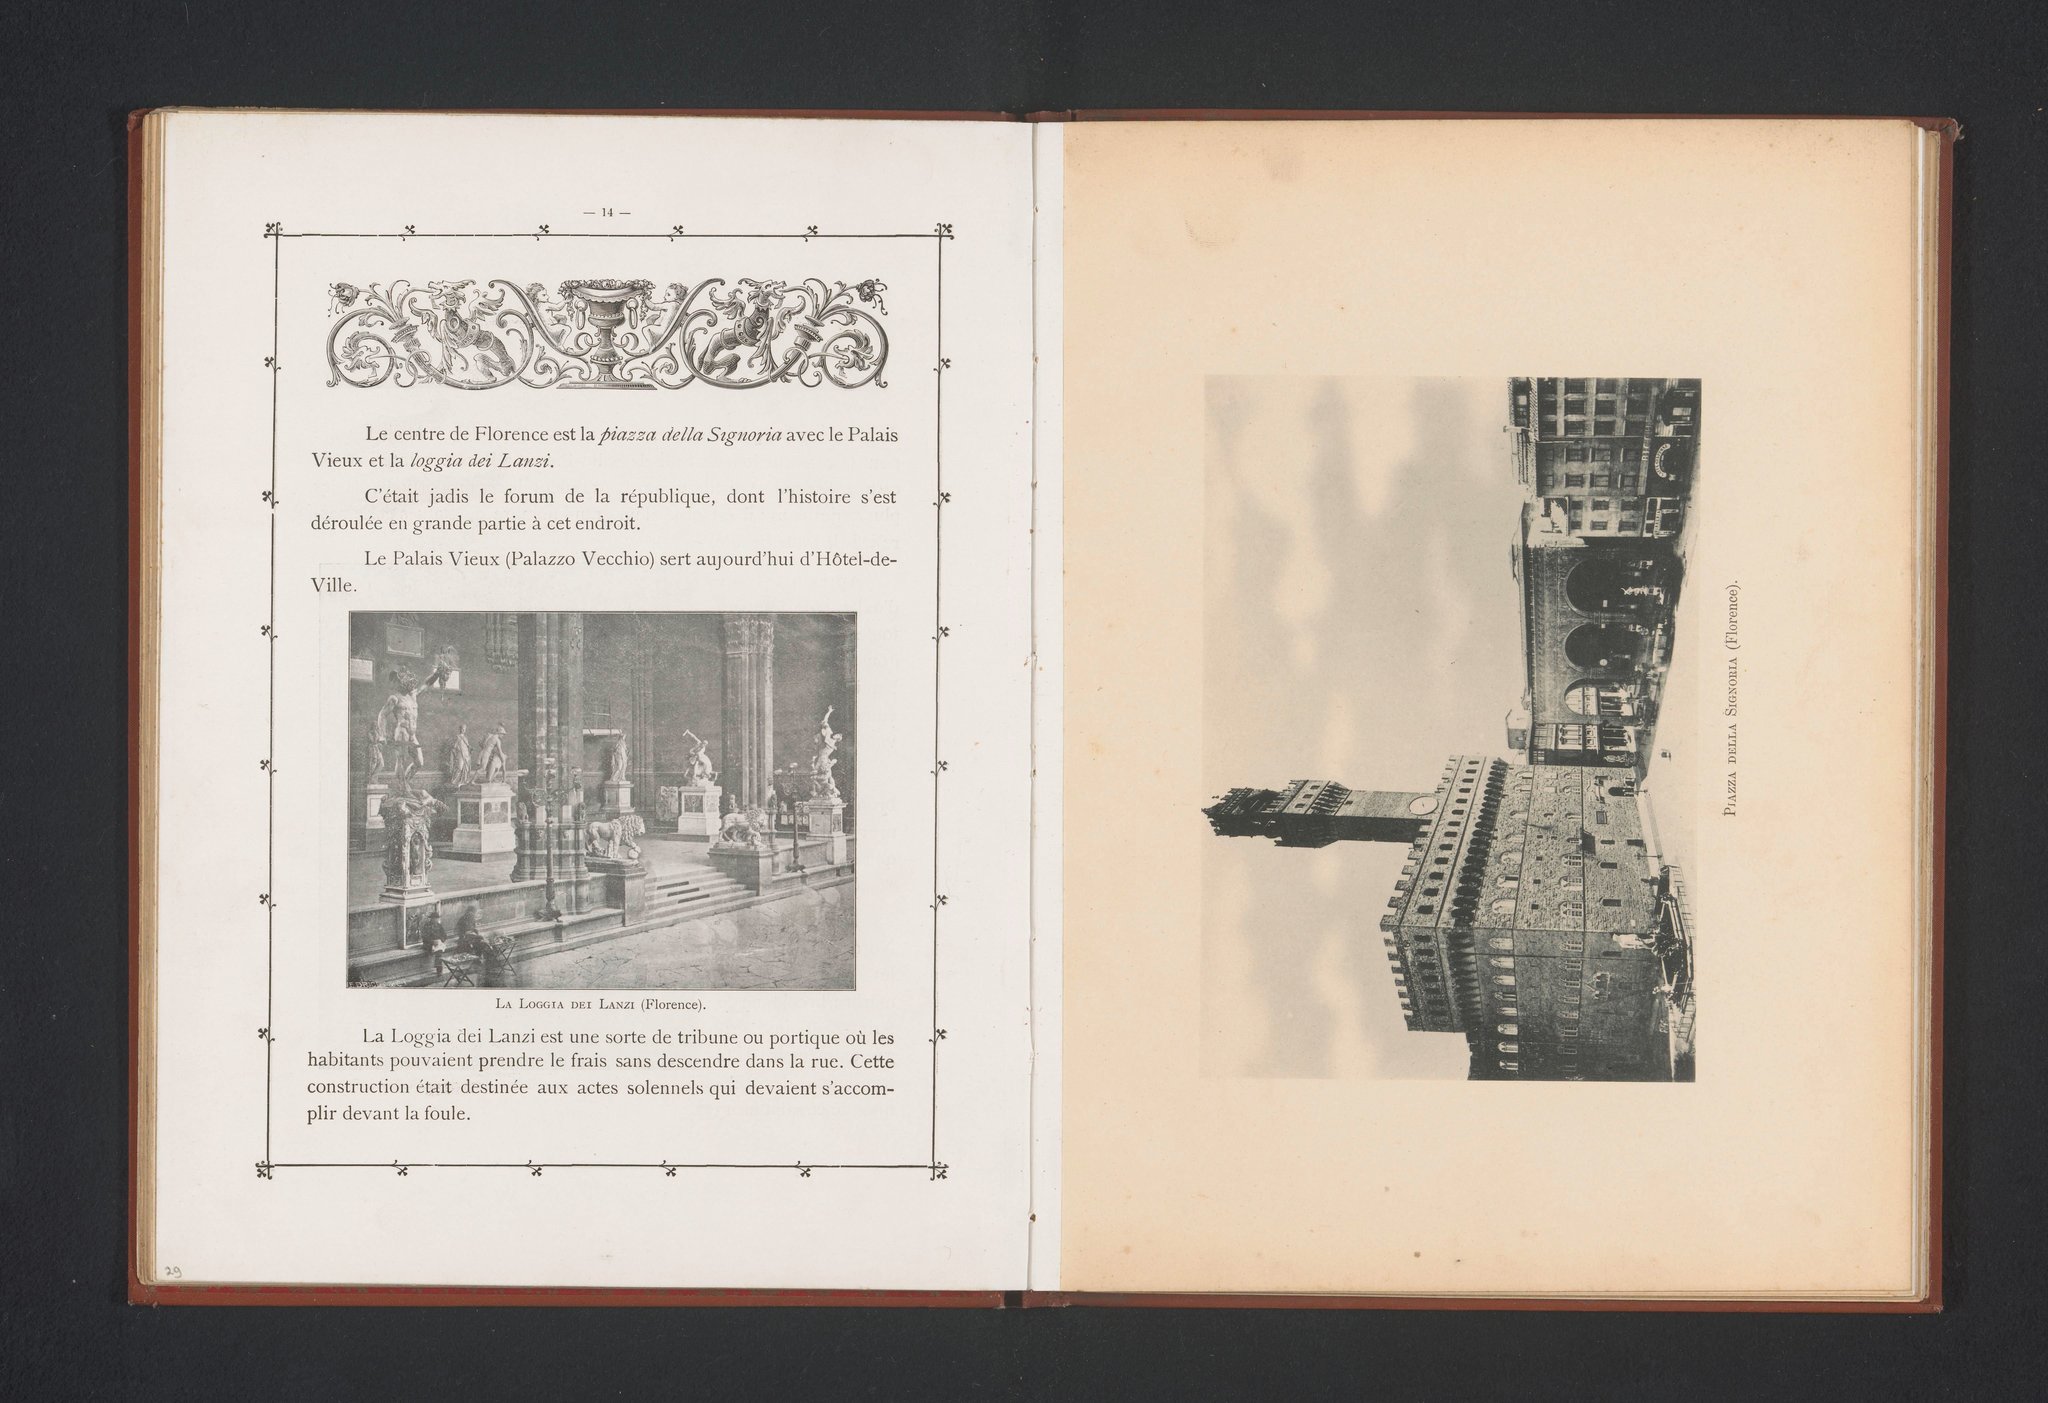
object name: photomechanical print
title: Piazza della Signoria (Florence)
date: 1893-1898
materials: paper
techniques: photograph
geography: florence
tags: square, place, circus, etc.